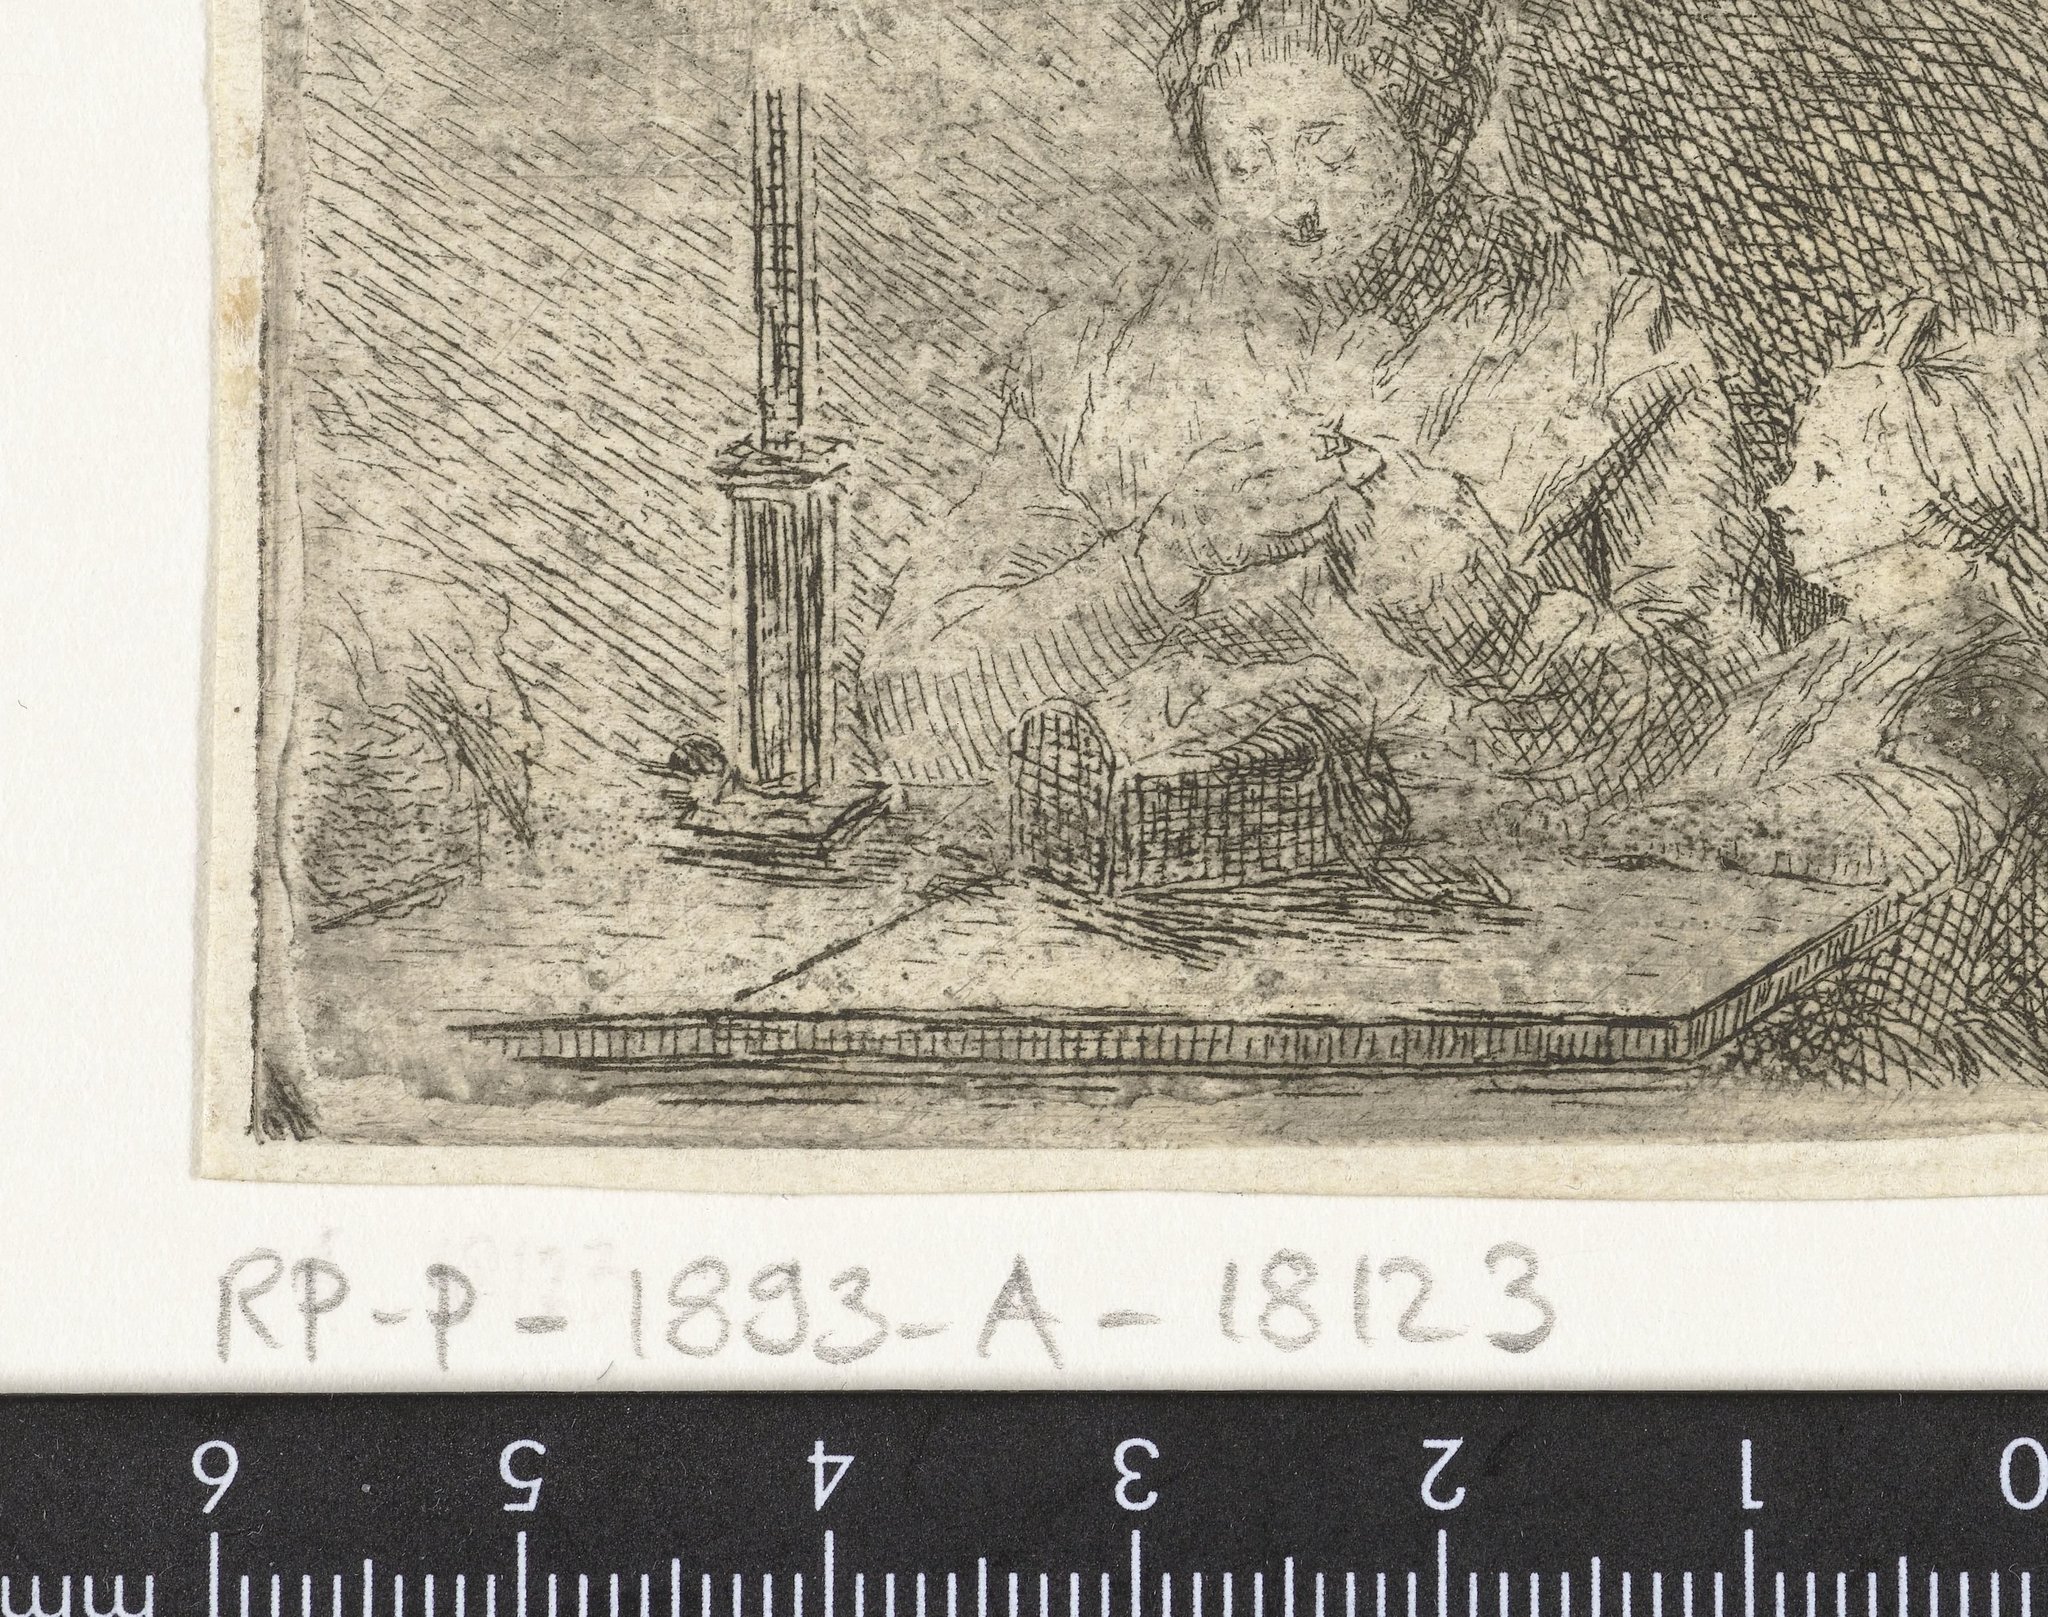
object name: print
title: Naaiende vrouw bij kaarslicht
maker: louis bernard coclers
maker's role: draughtsman, print maker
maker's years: 1741-1817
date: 1756-1817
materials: paper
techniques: aquatint, etching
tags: sewing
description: Een vrouw zit aan een tafel te naaien. Naast haar zit een kind. Op tafel staat een kandelaar met een brandende kaars.